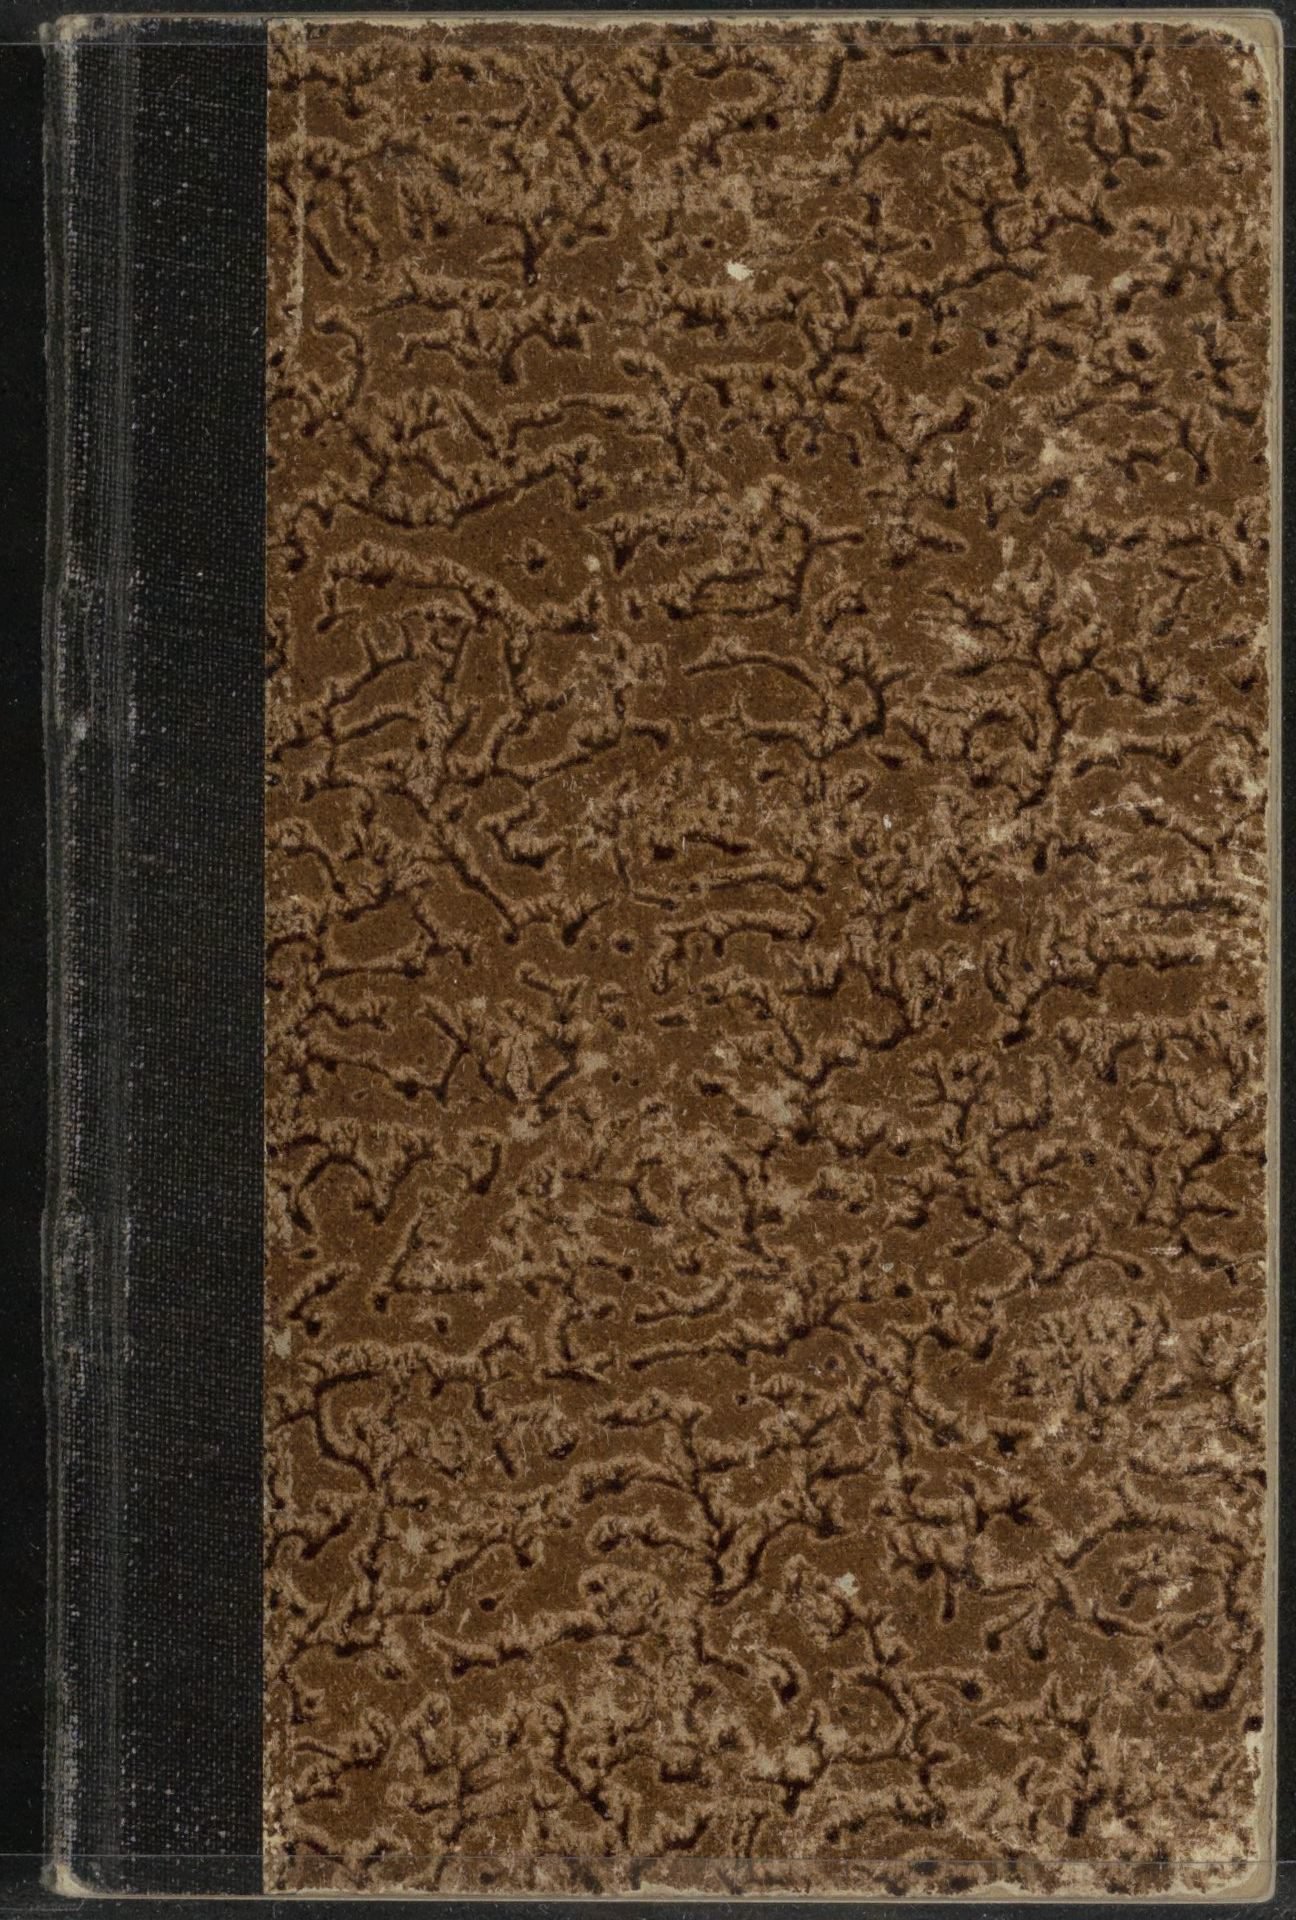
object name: sketchbook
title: Schetsboek met 46 bladen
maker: george hendrik breitner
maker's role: draughtsman, painter, print maker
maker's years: 1857-1923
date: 1886-1903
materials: chalk, paper, pencil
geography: amsterdam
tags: urban housing, street, amsterdam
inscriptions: retailer's mark: ‘Gebrs. Simons/ Amsterdam./ Filiaal/ Heiligenweg 34/ Kantoorboek & Papierhandel./ Linieer- en Perforeer-inrichting./ No. 141 Blanco/ Bij nabestelling van dit boek, gelieve men/ bovenstaand nummer op te geven. / per doz f 1.60 per stuk 15’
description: Schetsboek bestaande uit 46 bladen met voornamelijk gezichten te Amsterdam.